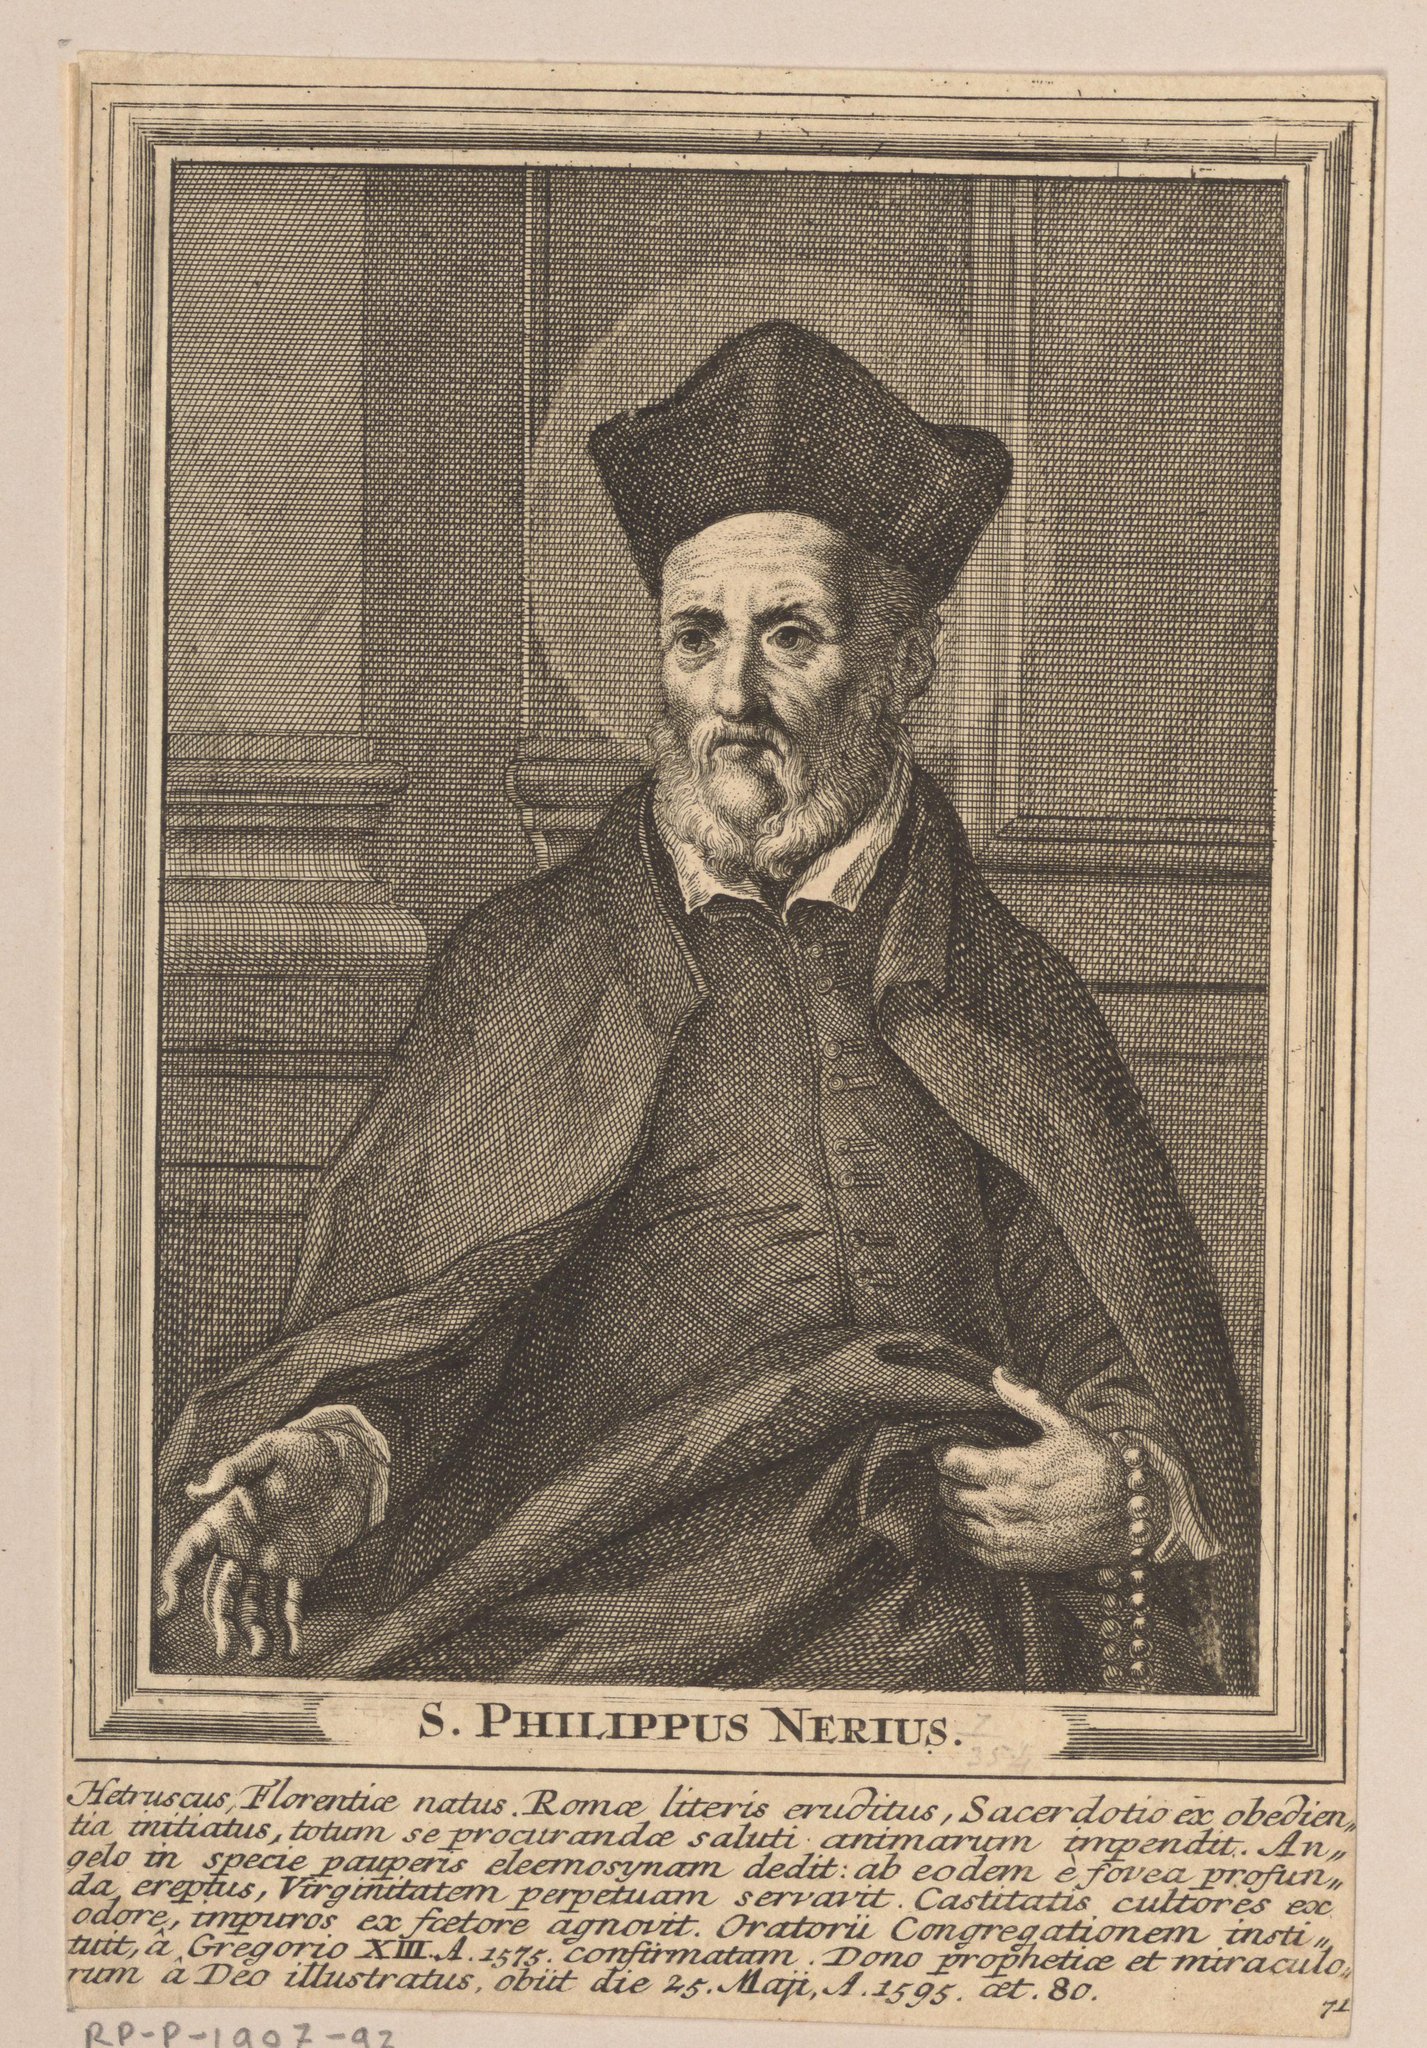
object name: print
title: Portret van Filippo Neri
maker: Anonymous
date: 1725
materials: paper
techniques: engraving, etching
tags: clergyman, priest (roman catholic), historical persons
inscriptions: collector's mark: Lugt 2228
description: Prent mogelijk uit: Pfeiffersberg, Karl. Columnae militantis ecclesiae sive Sancti et Illustres viri (...). Neurenberg: Christoph Weigel, 1725.